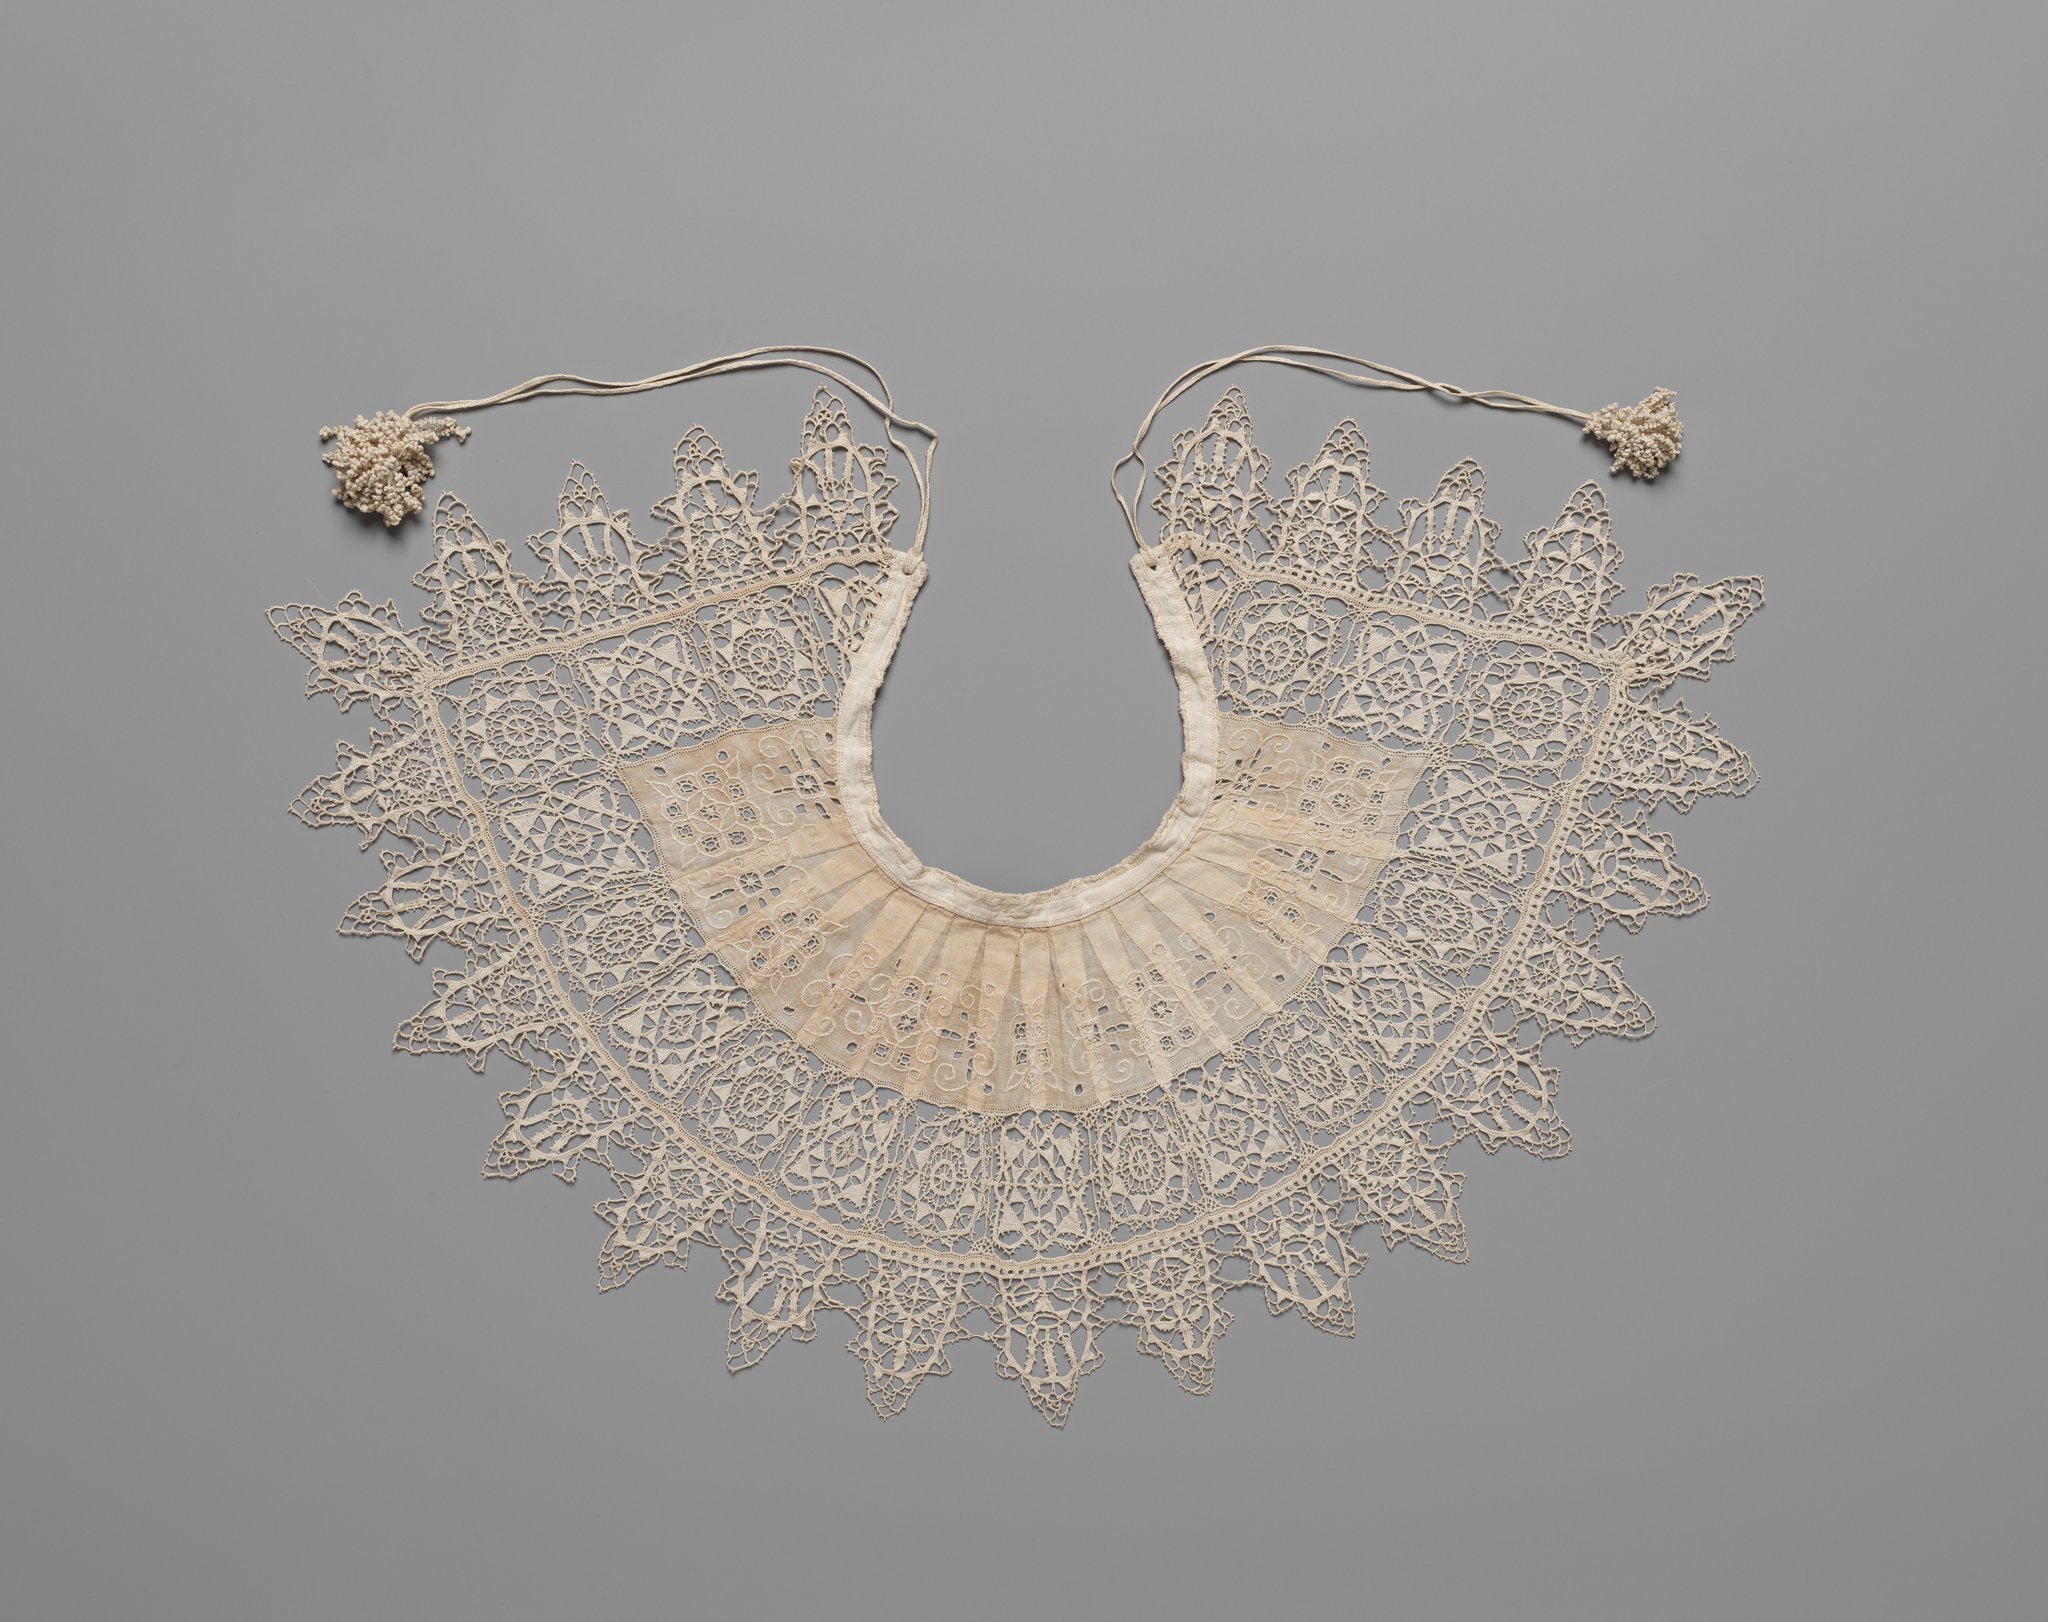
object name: collar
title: Standing band (collar) with tassels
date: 1610-1620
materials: linen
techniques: embroidery, lace